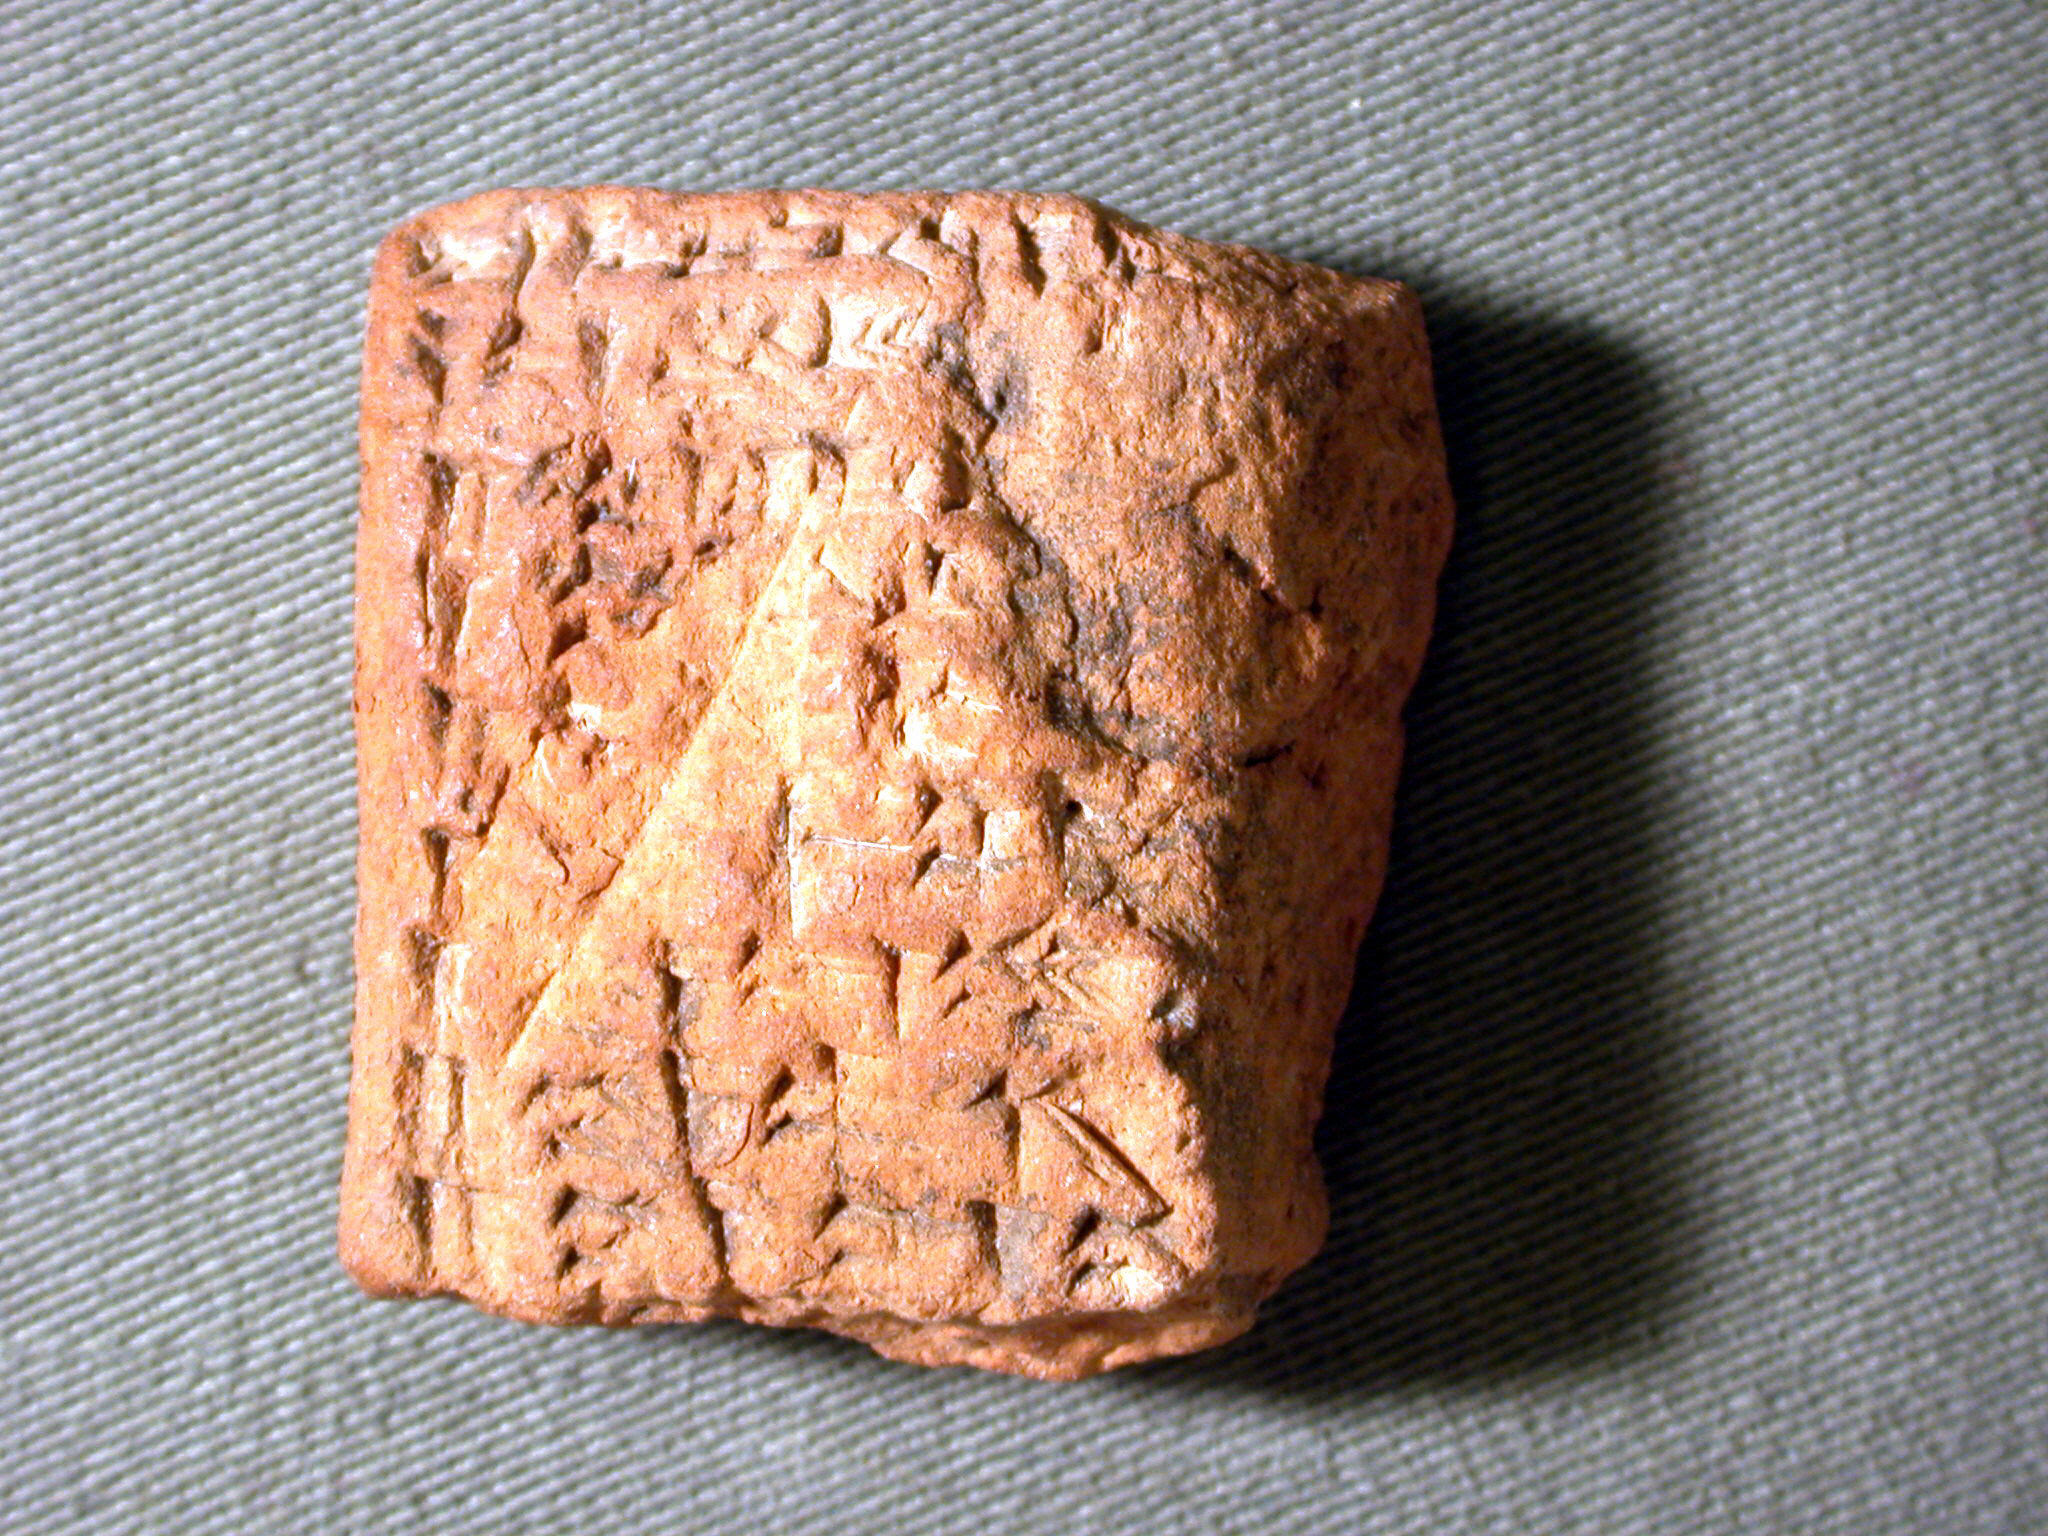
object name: cuneiform tablet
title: Cuneiform tablet: unidentified fragment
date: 333-1 BCE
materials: clay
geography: mesopotamia